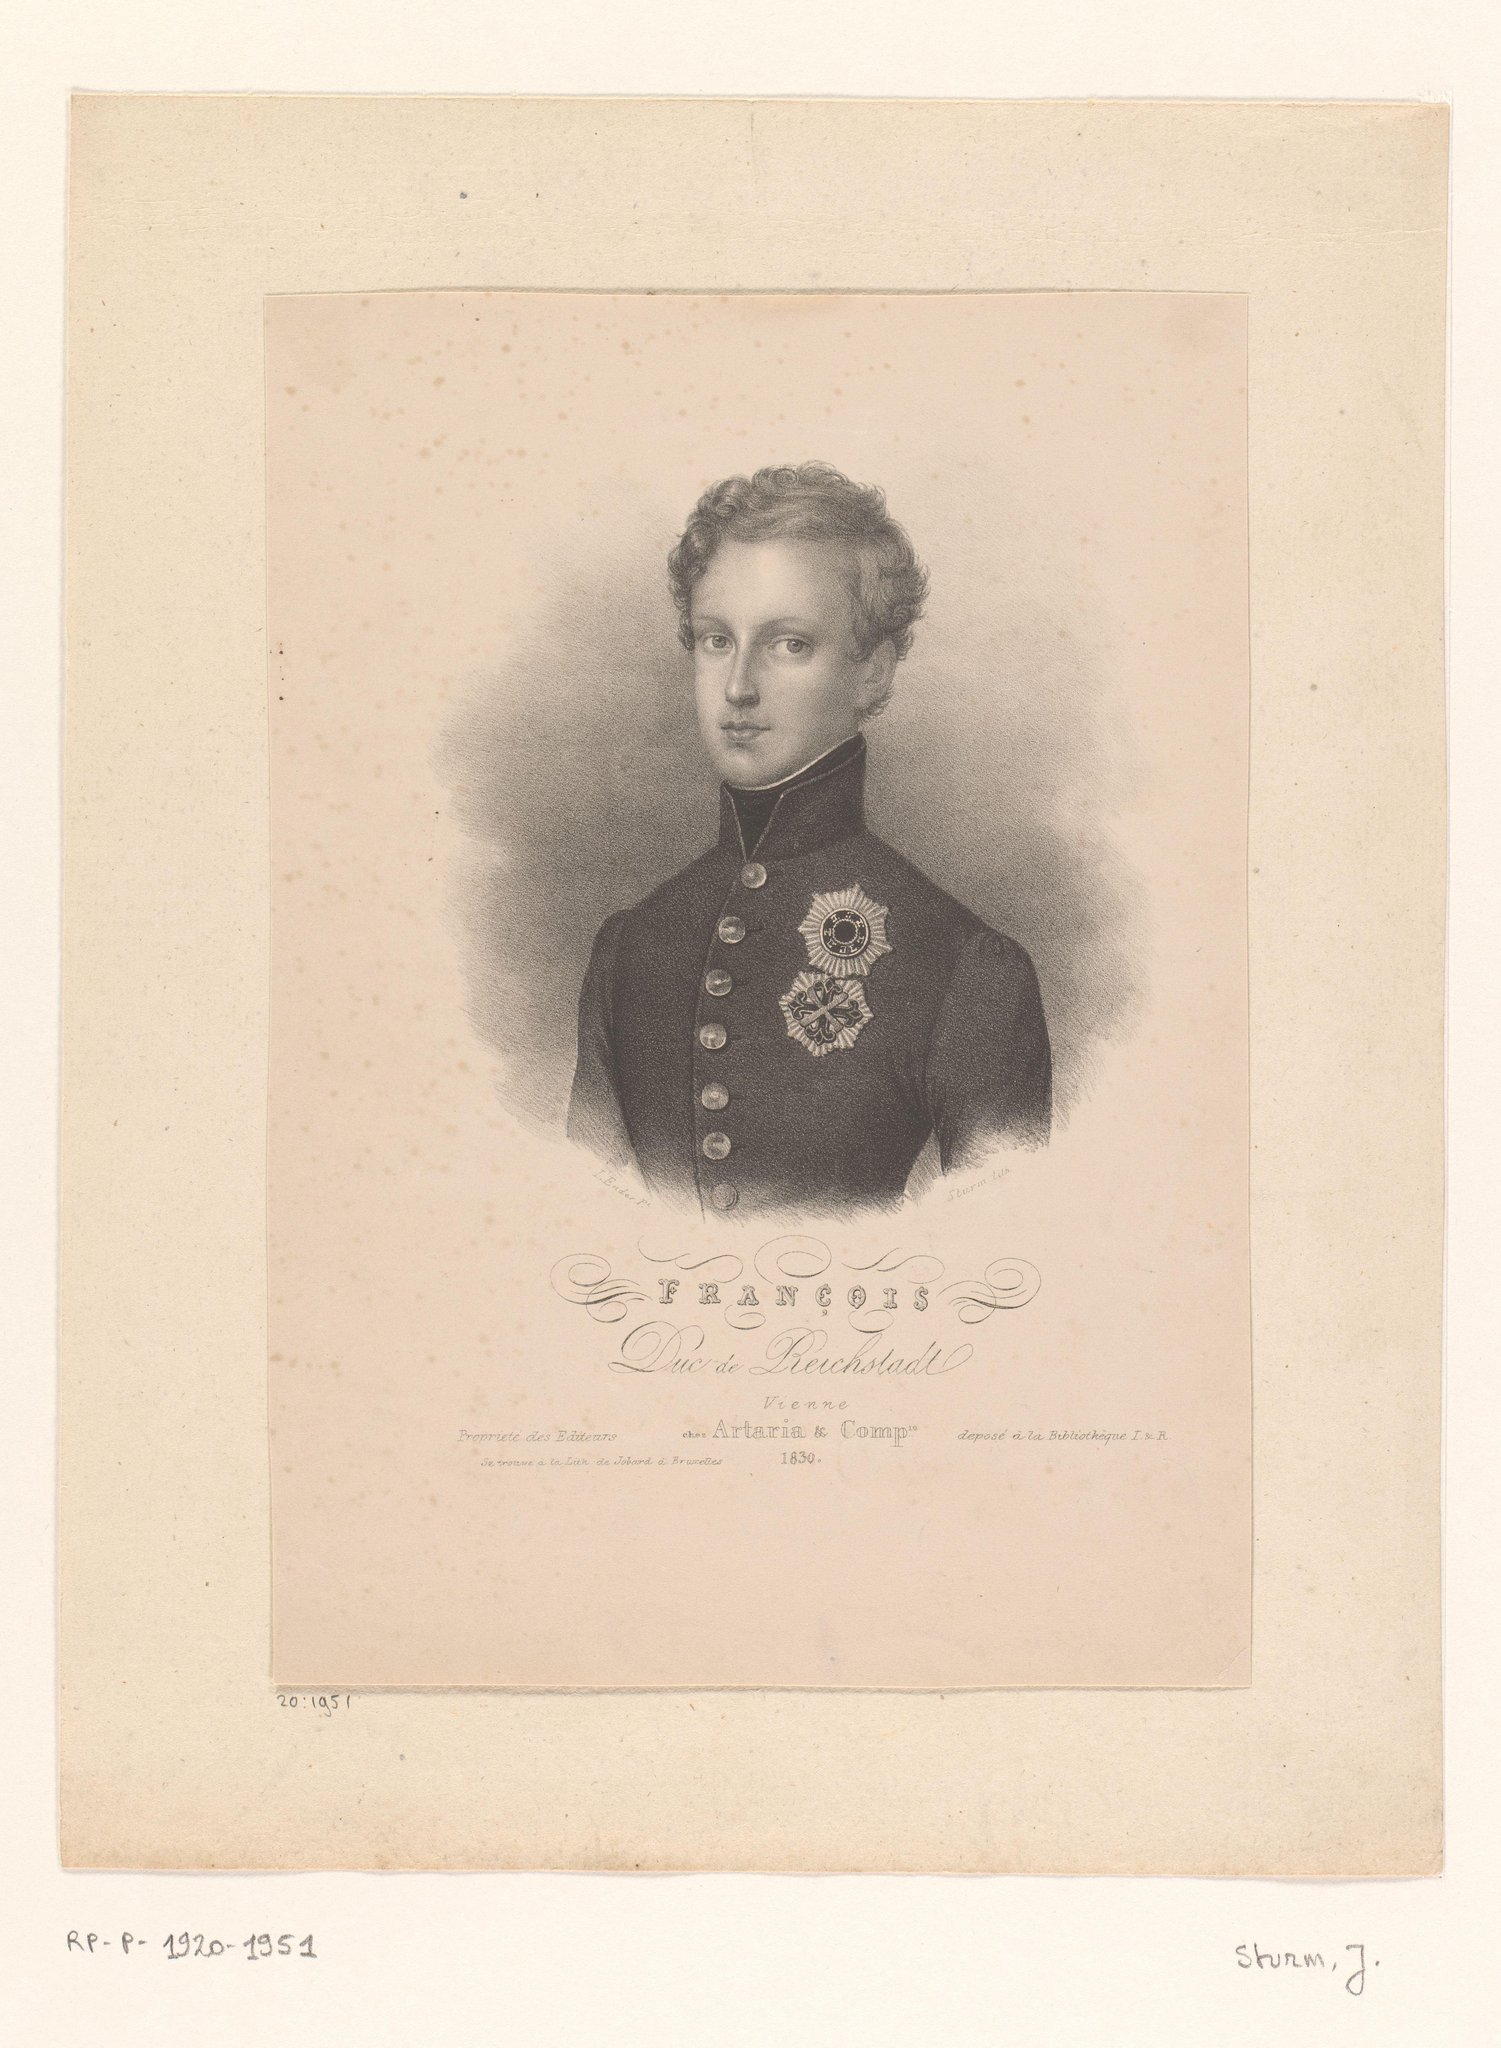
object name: print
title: Portret van Napoleon Frans Karel Jozef Bonaparte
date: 1830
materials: paper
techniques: lithograph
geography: vienna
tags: paris, vienna, historical persons, youth, adolescent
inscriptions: : ‘Propriete des Editeurs’, : ‘Deposé à la Bibliothèque I&R.’, collector's mark: Lugt 2228